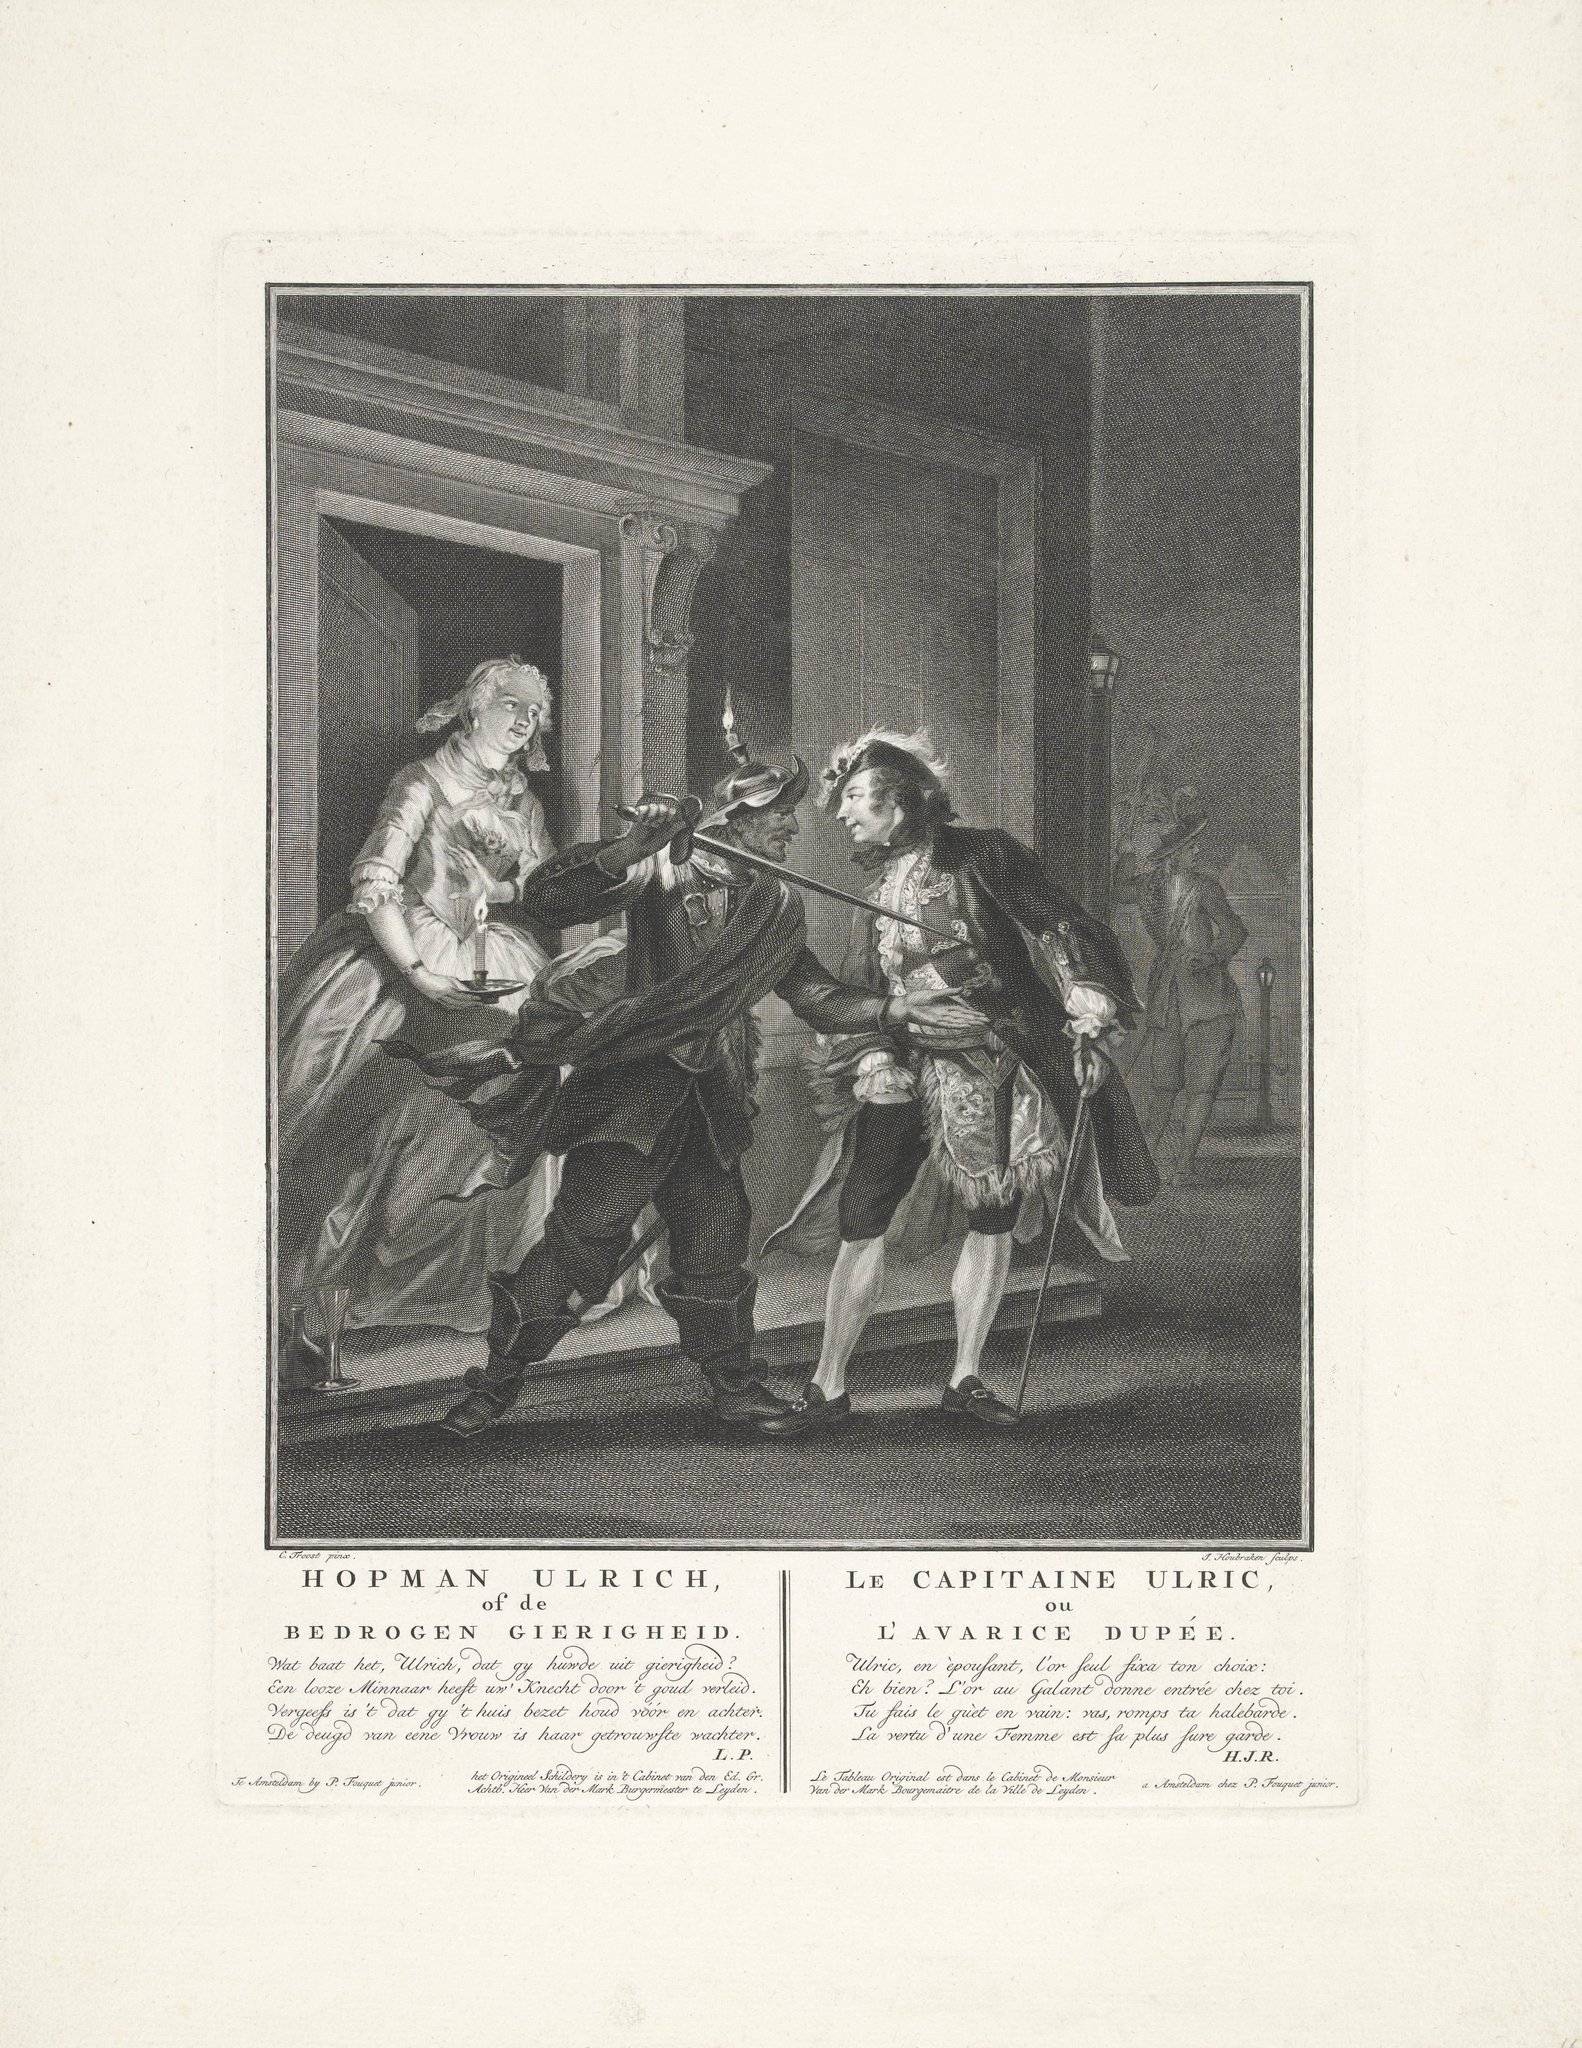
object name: print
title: Hopman Ulrich of de bedrogen gierigheid: de omkoping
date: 1760-1780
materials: paper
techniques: engraving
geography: amsterdam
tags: comedy, candlestick, guard duty, keeping sentry, night, bribery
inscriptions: collector's mark: Lugt 2233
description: Een wachter met een zwaard vraagt een jongeman (Godefroy), die heimelijk in de nacht bij zijn geliefde (Sybille) op bezoek komt, om geld. De jongeman steekt zijn hand in zijn broekzak. De vrouw heeft een kaars vast. Op de stoep staan een glas en een fles. Rechts op de achtergrond een tweede wachter. Scène uit het blijspel 'Hopman Ulrich of de bedrogen gierigheid' van Johan van Paffenrode uit 1661, waarin het gierige personage Ulrich wordt bedrogen door zijn vrouw Sybille, ondanks dat hij haar laat bewaken. Haar minnaar Godefroy koopt de wachter om.